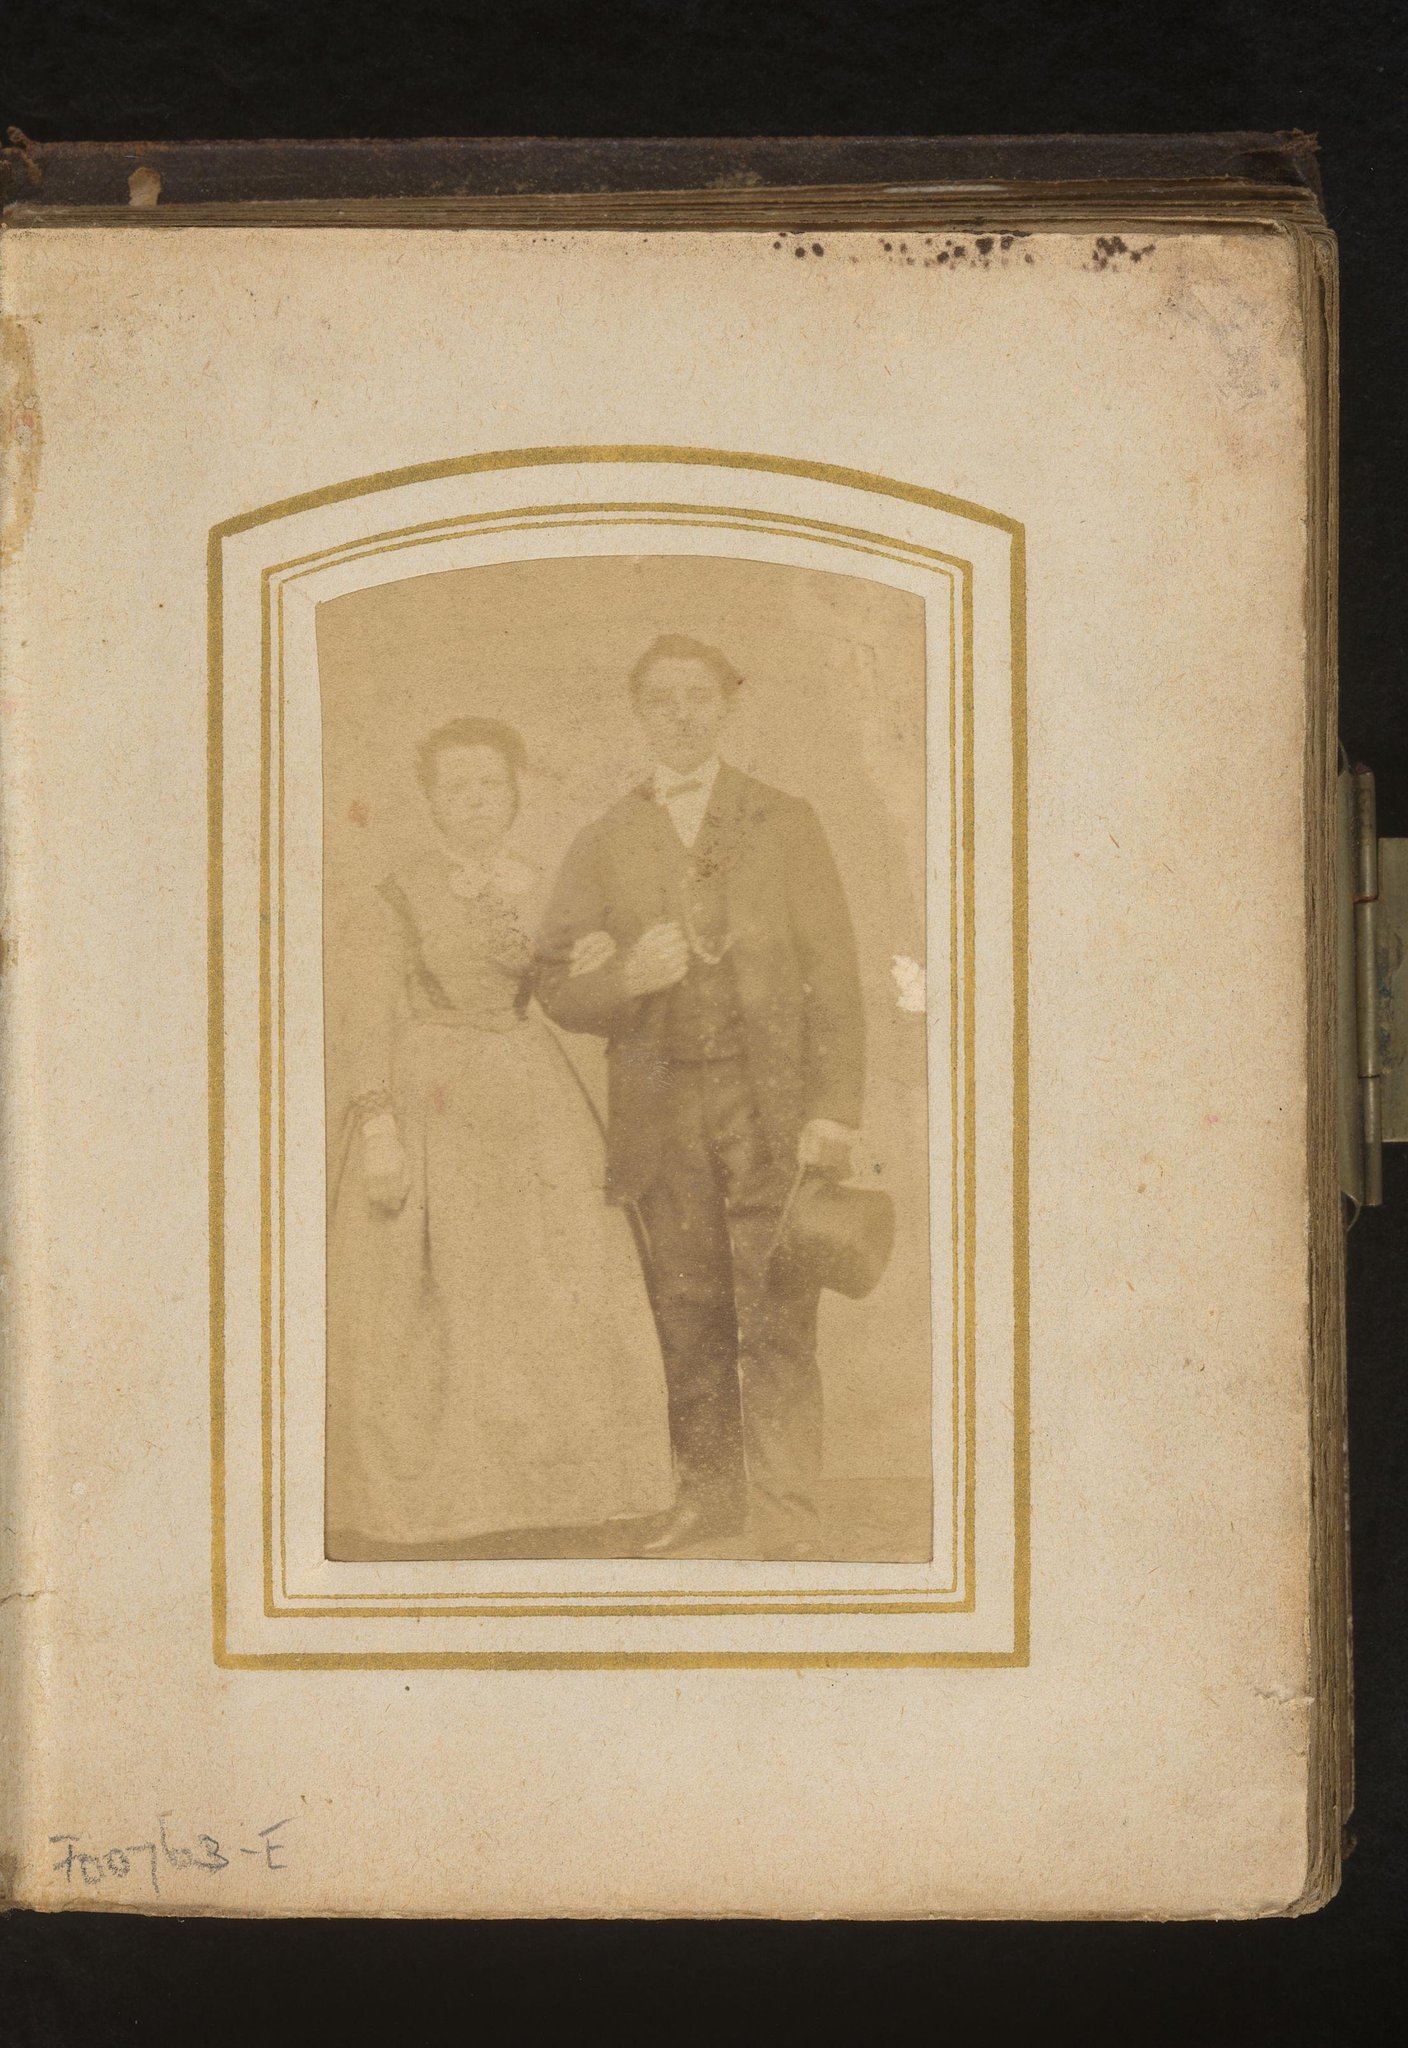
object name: album leaf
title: Portret van een man met hoed in de hand en een vrouw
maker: johannes hermannus holman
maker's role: fotograaf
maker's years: 1833-1919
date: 1875-1899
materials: cardboard, photographic support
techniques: albumen print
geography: groningen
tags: historical persons - bb - woman, historical persons, head-gear: hat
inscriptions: inscription: ‘J. H. HOLMAN/ Folkingestraat/ GRONINGEN’